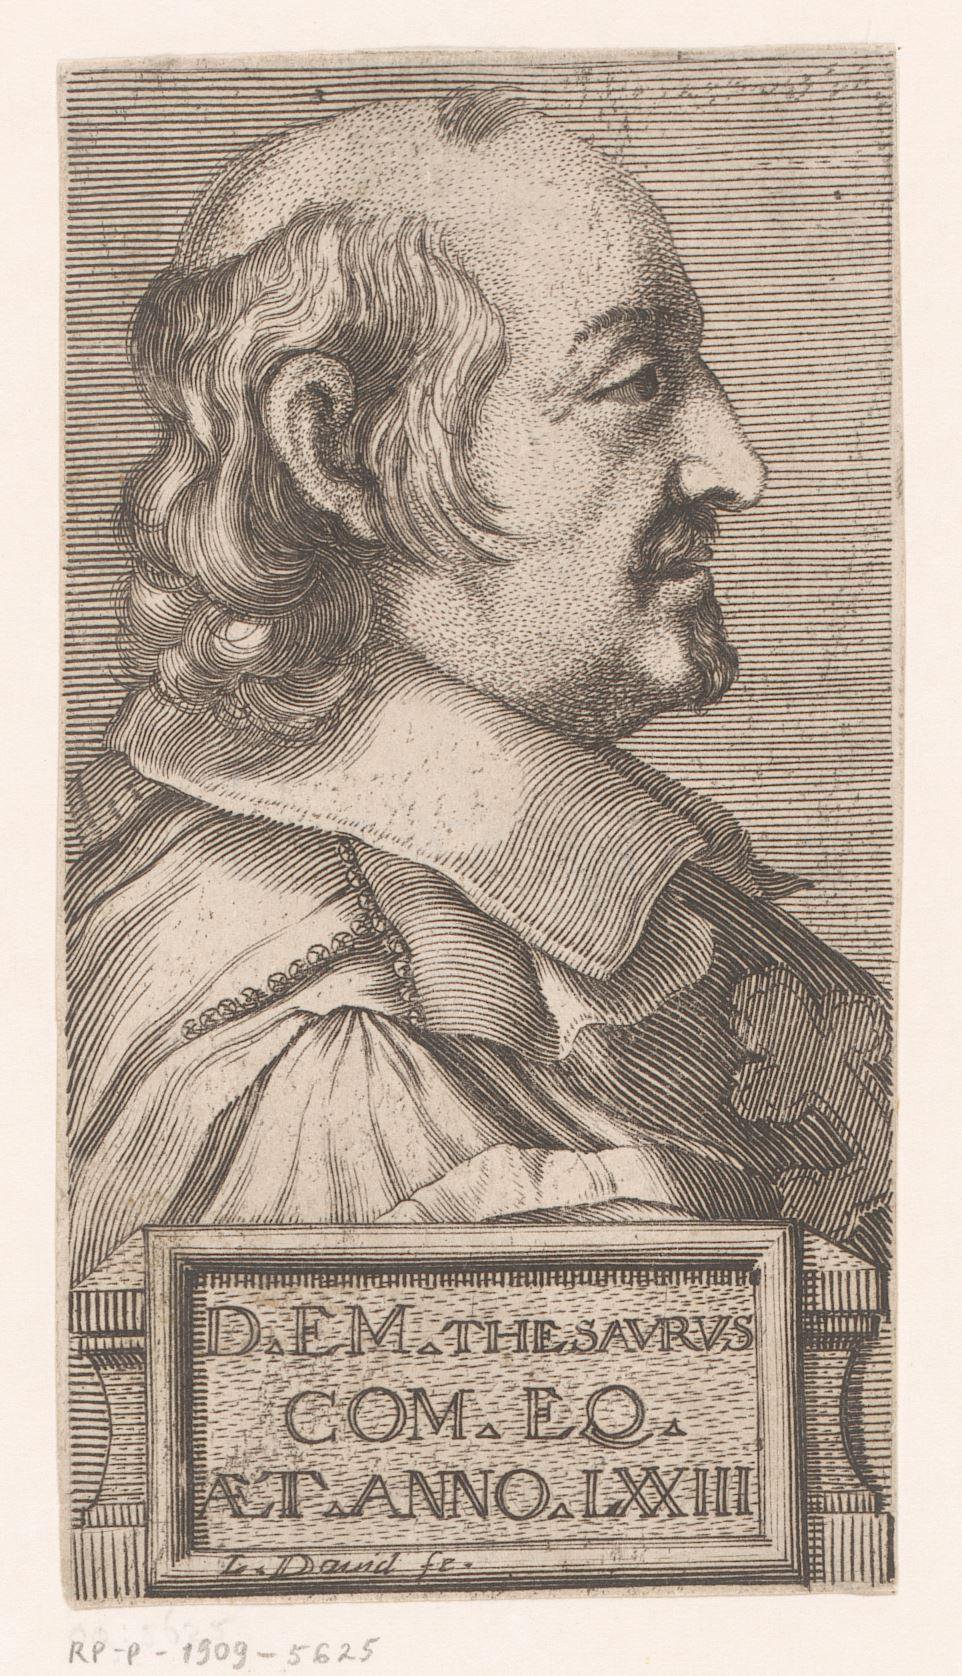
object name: print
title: D. EM. Thesaurus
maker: louis david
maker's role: print maker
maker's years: 1667-1718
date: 1677-1718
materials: paper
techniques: engraving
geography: france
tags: portrait of a writer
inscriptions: collector's mark: Lugt 2228